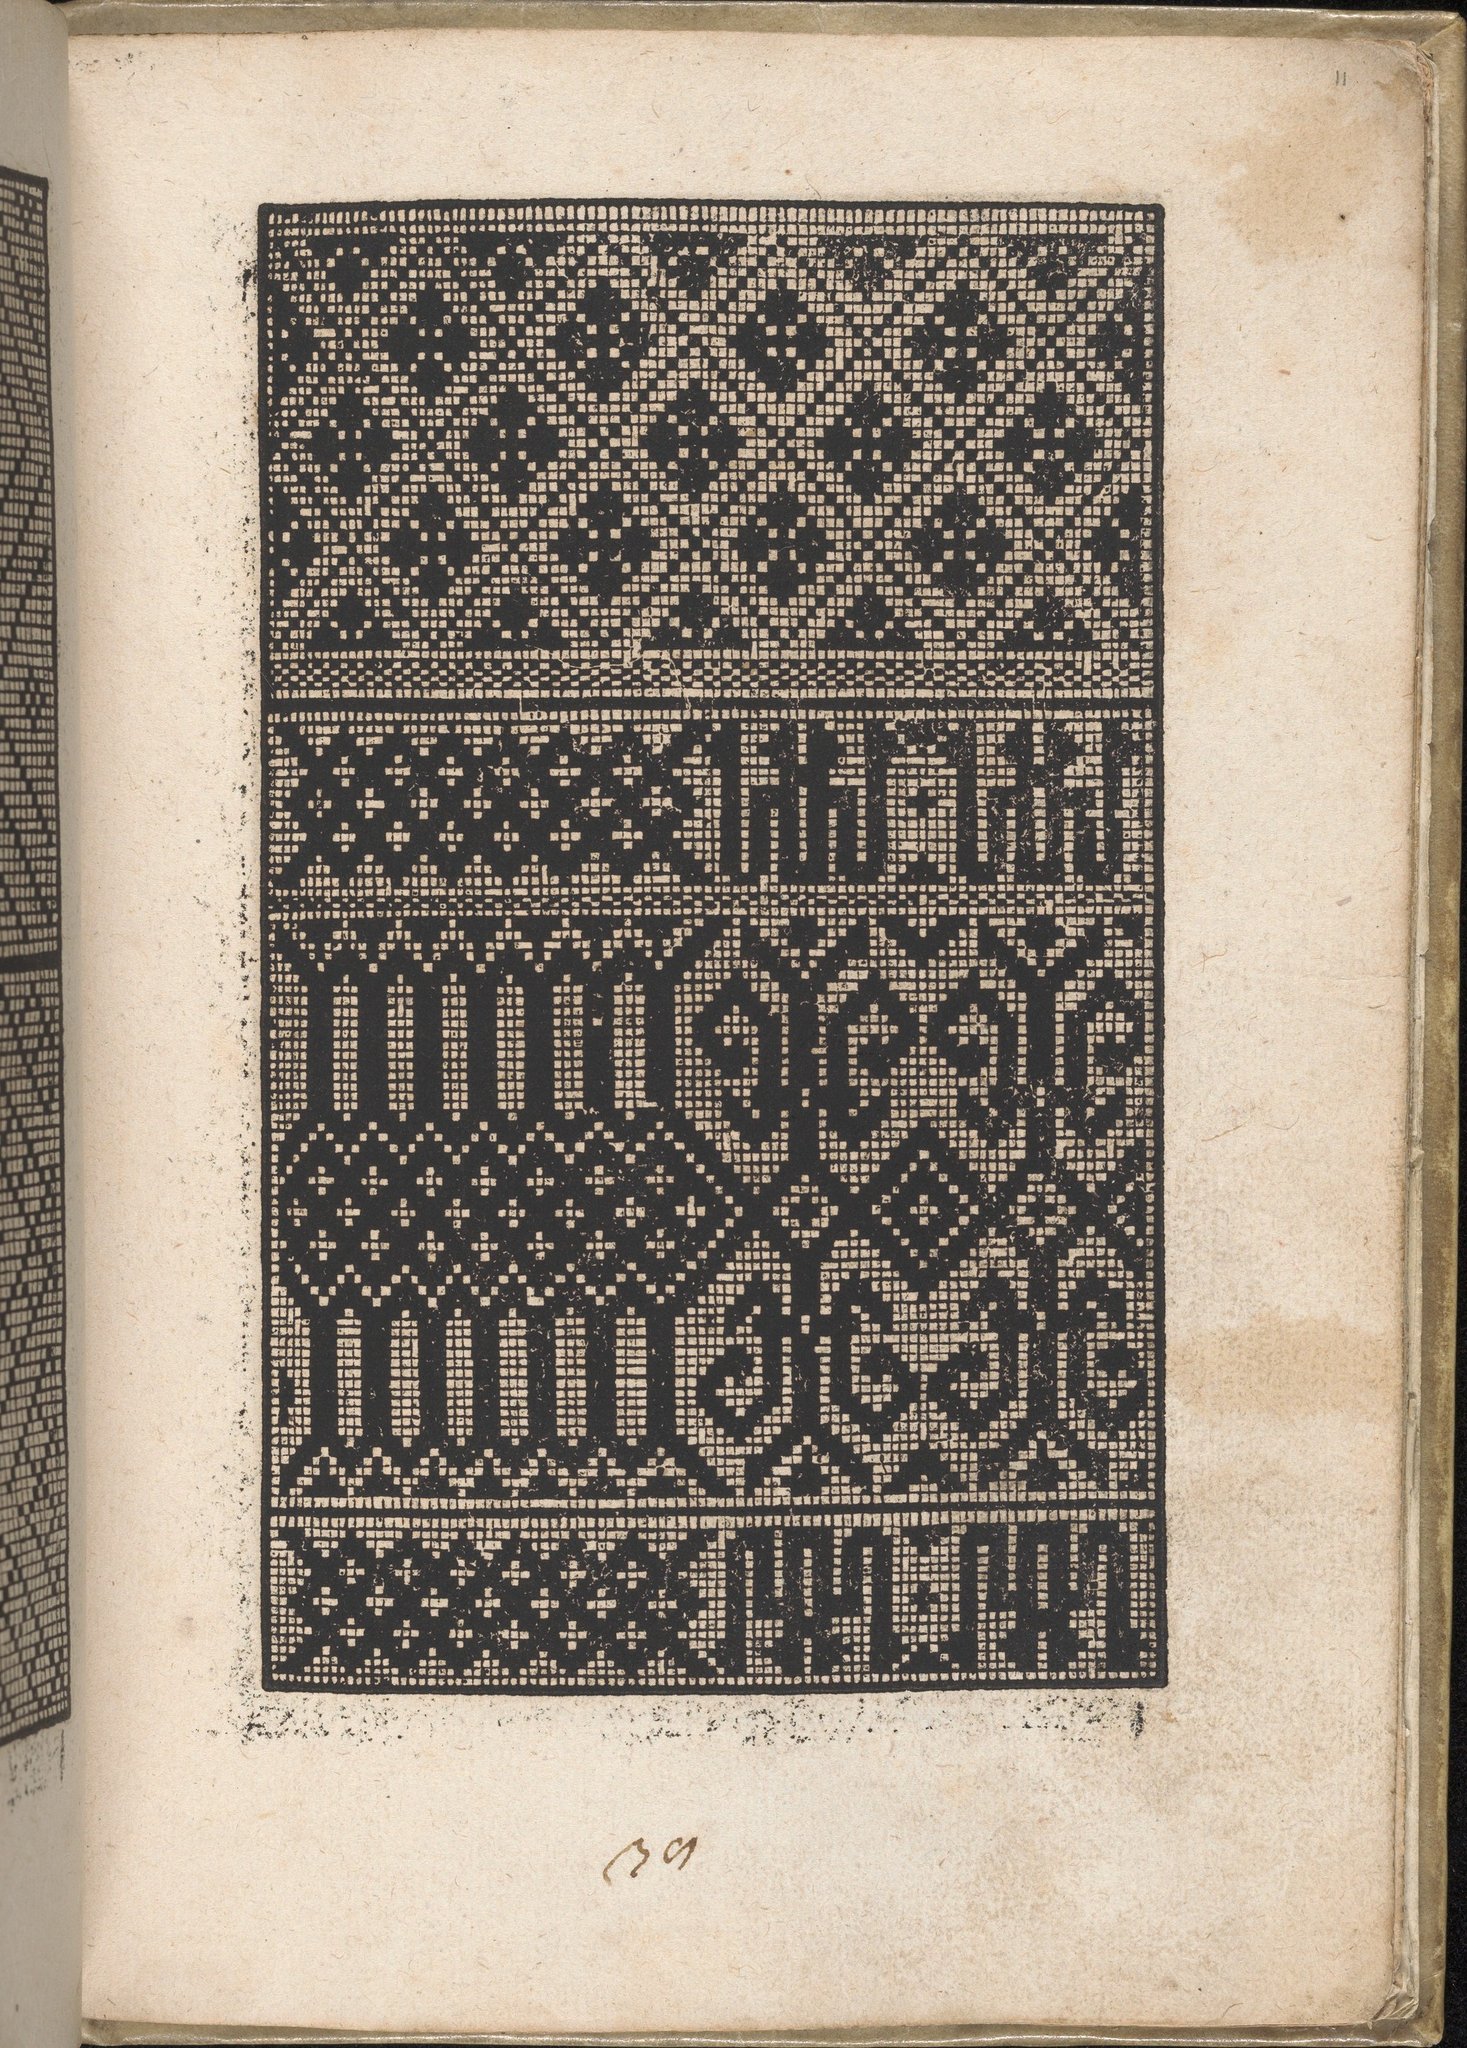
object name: book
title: Page 11v, from "Eyn New Kunstlichboich"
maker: peter quentel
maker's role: publisher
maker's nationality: german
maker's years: 1500-1550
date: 1529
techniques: woodcut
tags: ornament